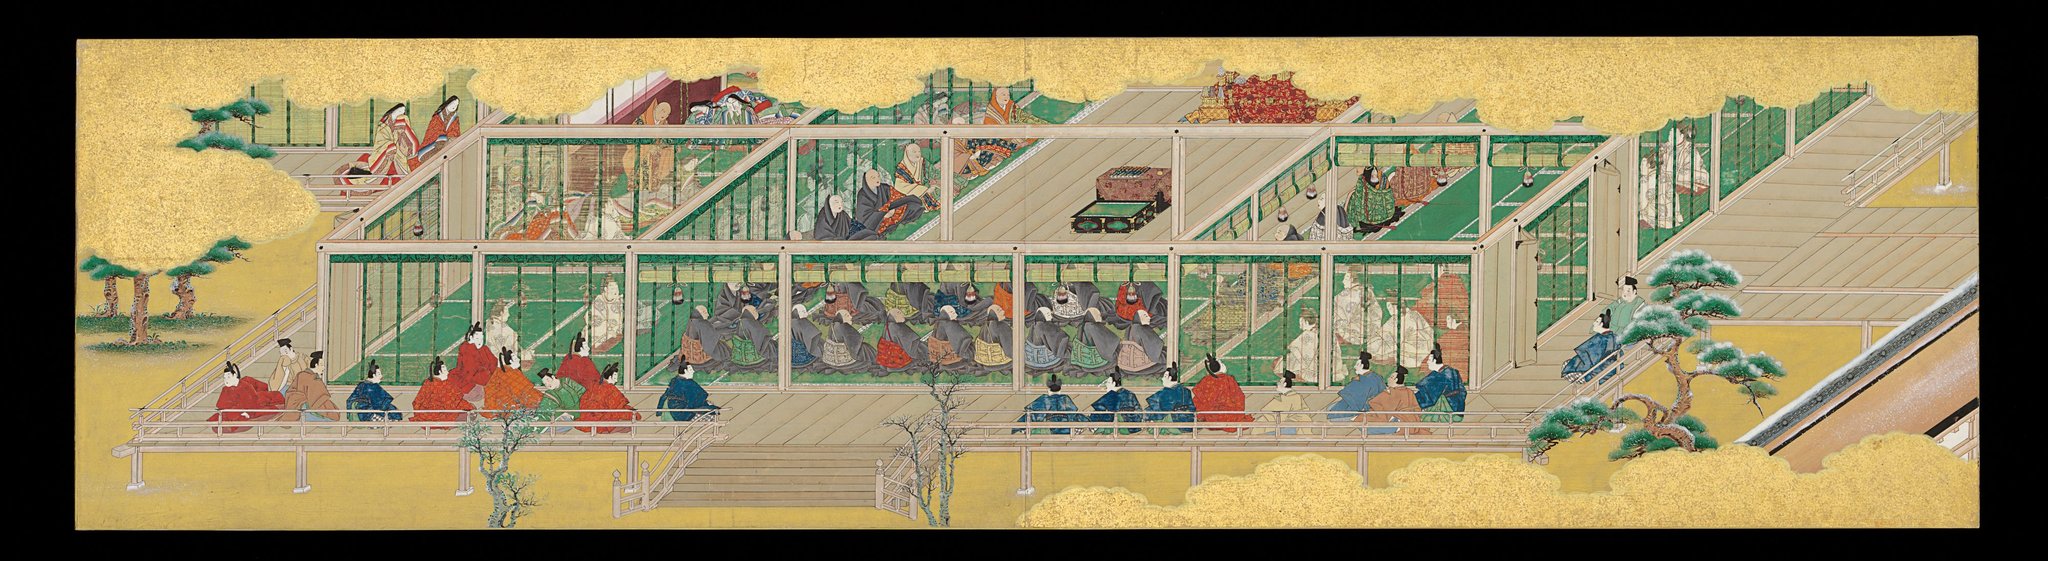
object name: handscroll section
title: “A Branch of Sacred Evergreen” (Sakaki), from the Phantom Genji Scrolls (Maboroshi no Genji monogatari emaki)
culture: japanese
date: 1634-1666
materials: board, gold, ink, paper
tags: interiors,men